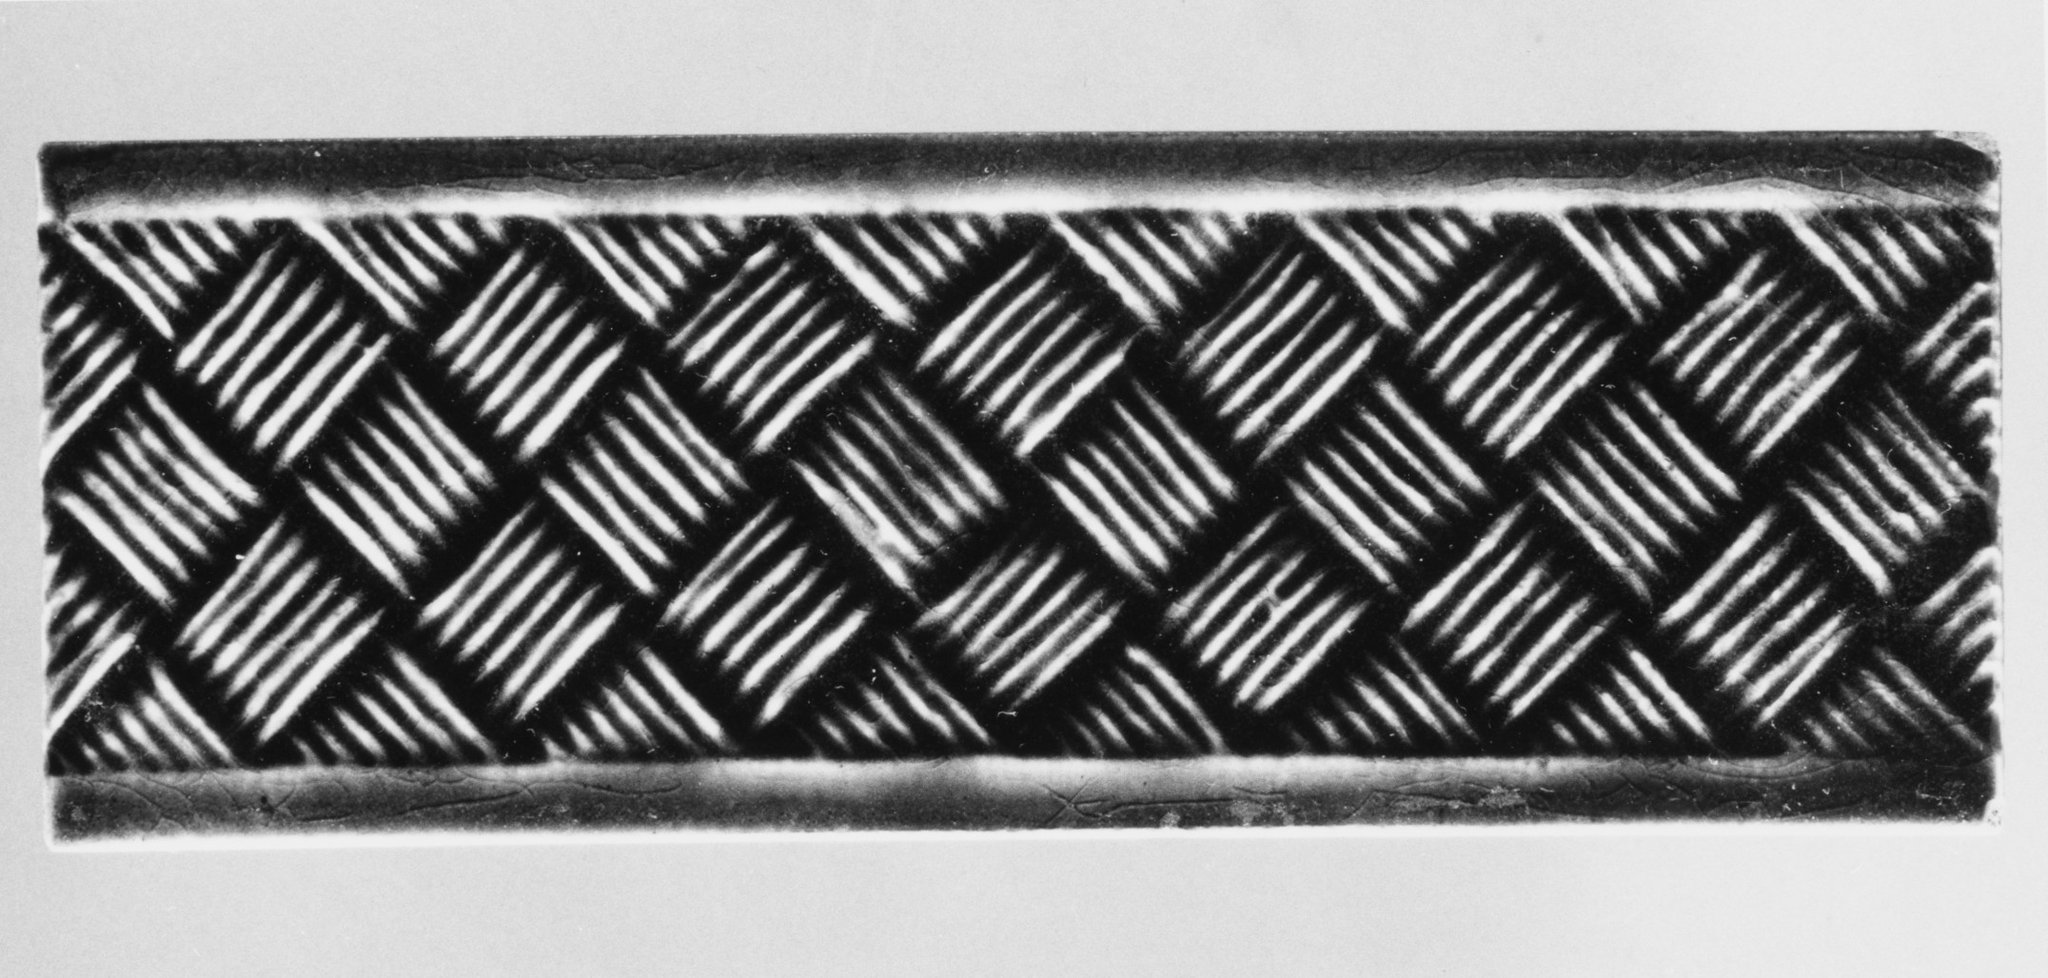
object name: tile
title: Border Tile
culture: american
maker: j. and j. g. low art tile works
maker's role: maker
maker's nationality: american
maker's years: 1877-1903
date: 1881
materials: earthenware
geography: united states